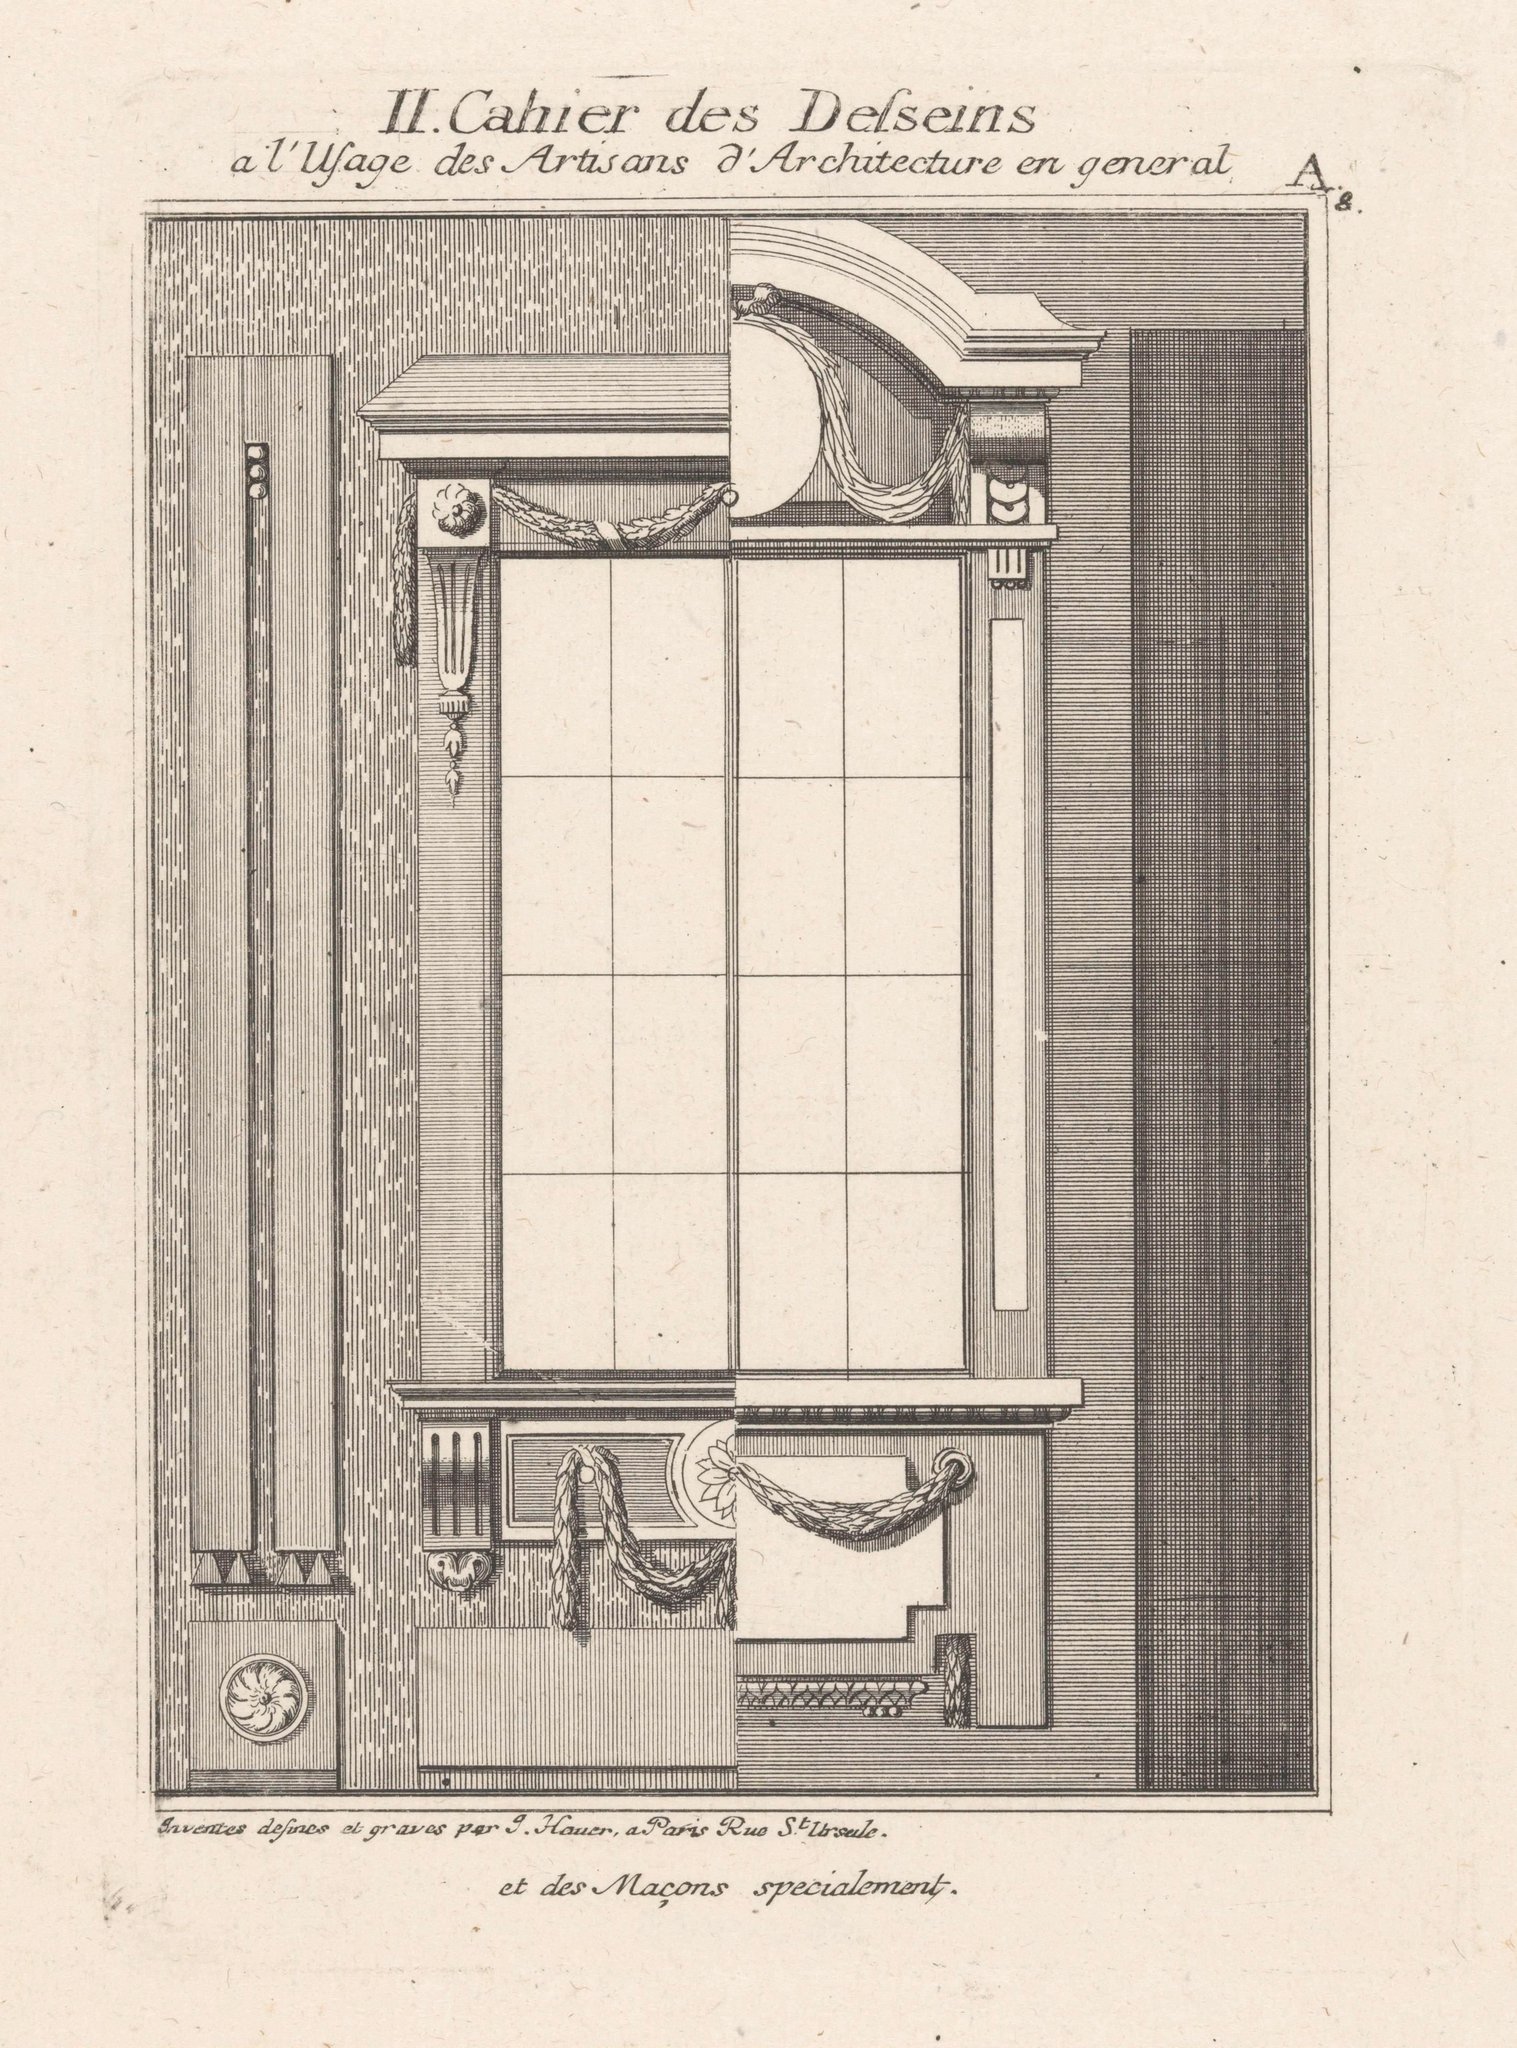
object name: ornament print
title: Desseins de la Mode neuve au Gout antique (...)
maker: johann thomas hauer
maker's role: print maker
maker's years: 1748-1820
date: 1758-1820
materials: paper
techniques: engraving, etching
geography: paris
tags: ornaments ~ art (+ framing decorations)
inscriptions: collector's mark: Lugt 2228, collector's mark: Lugt 2760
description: Ontwerp voor een vensteromlijsting met guirlandes, bloemmotieven en een ovaal schild.